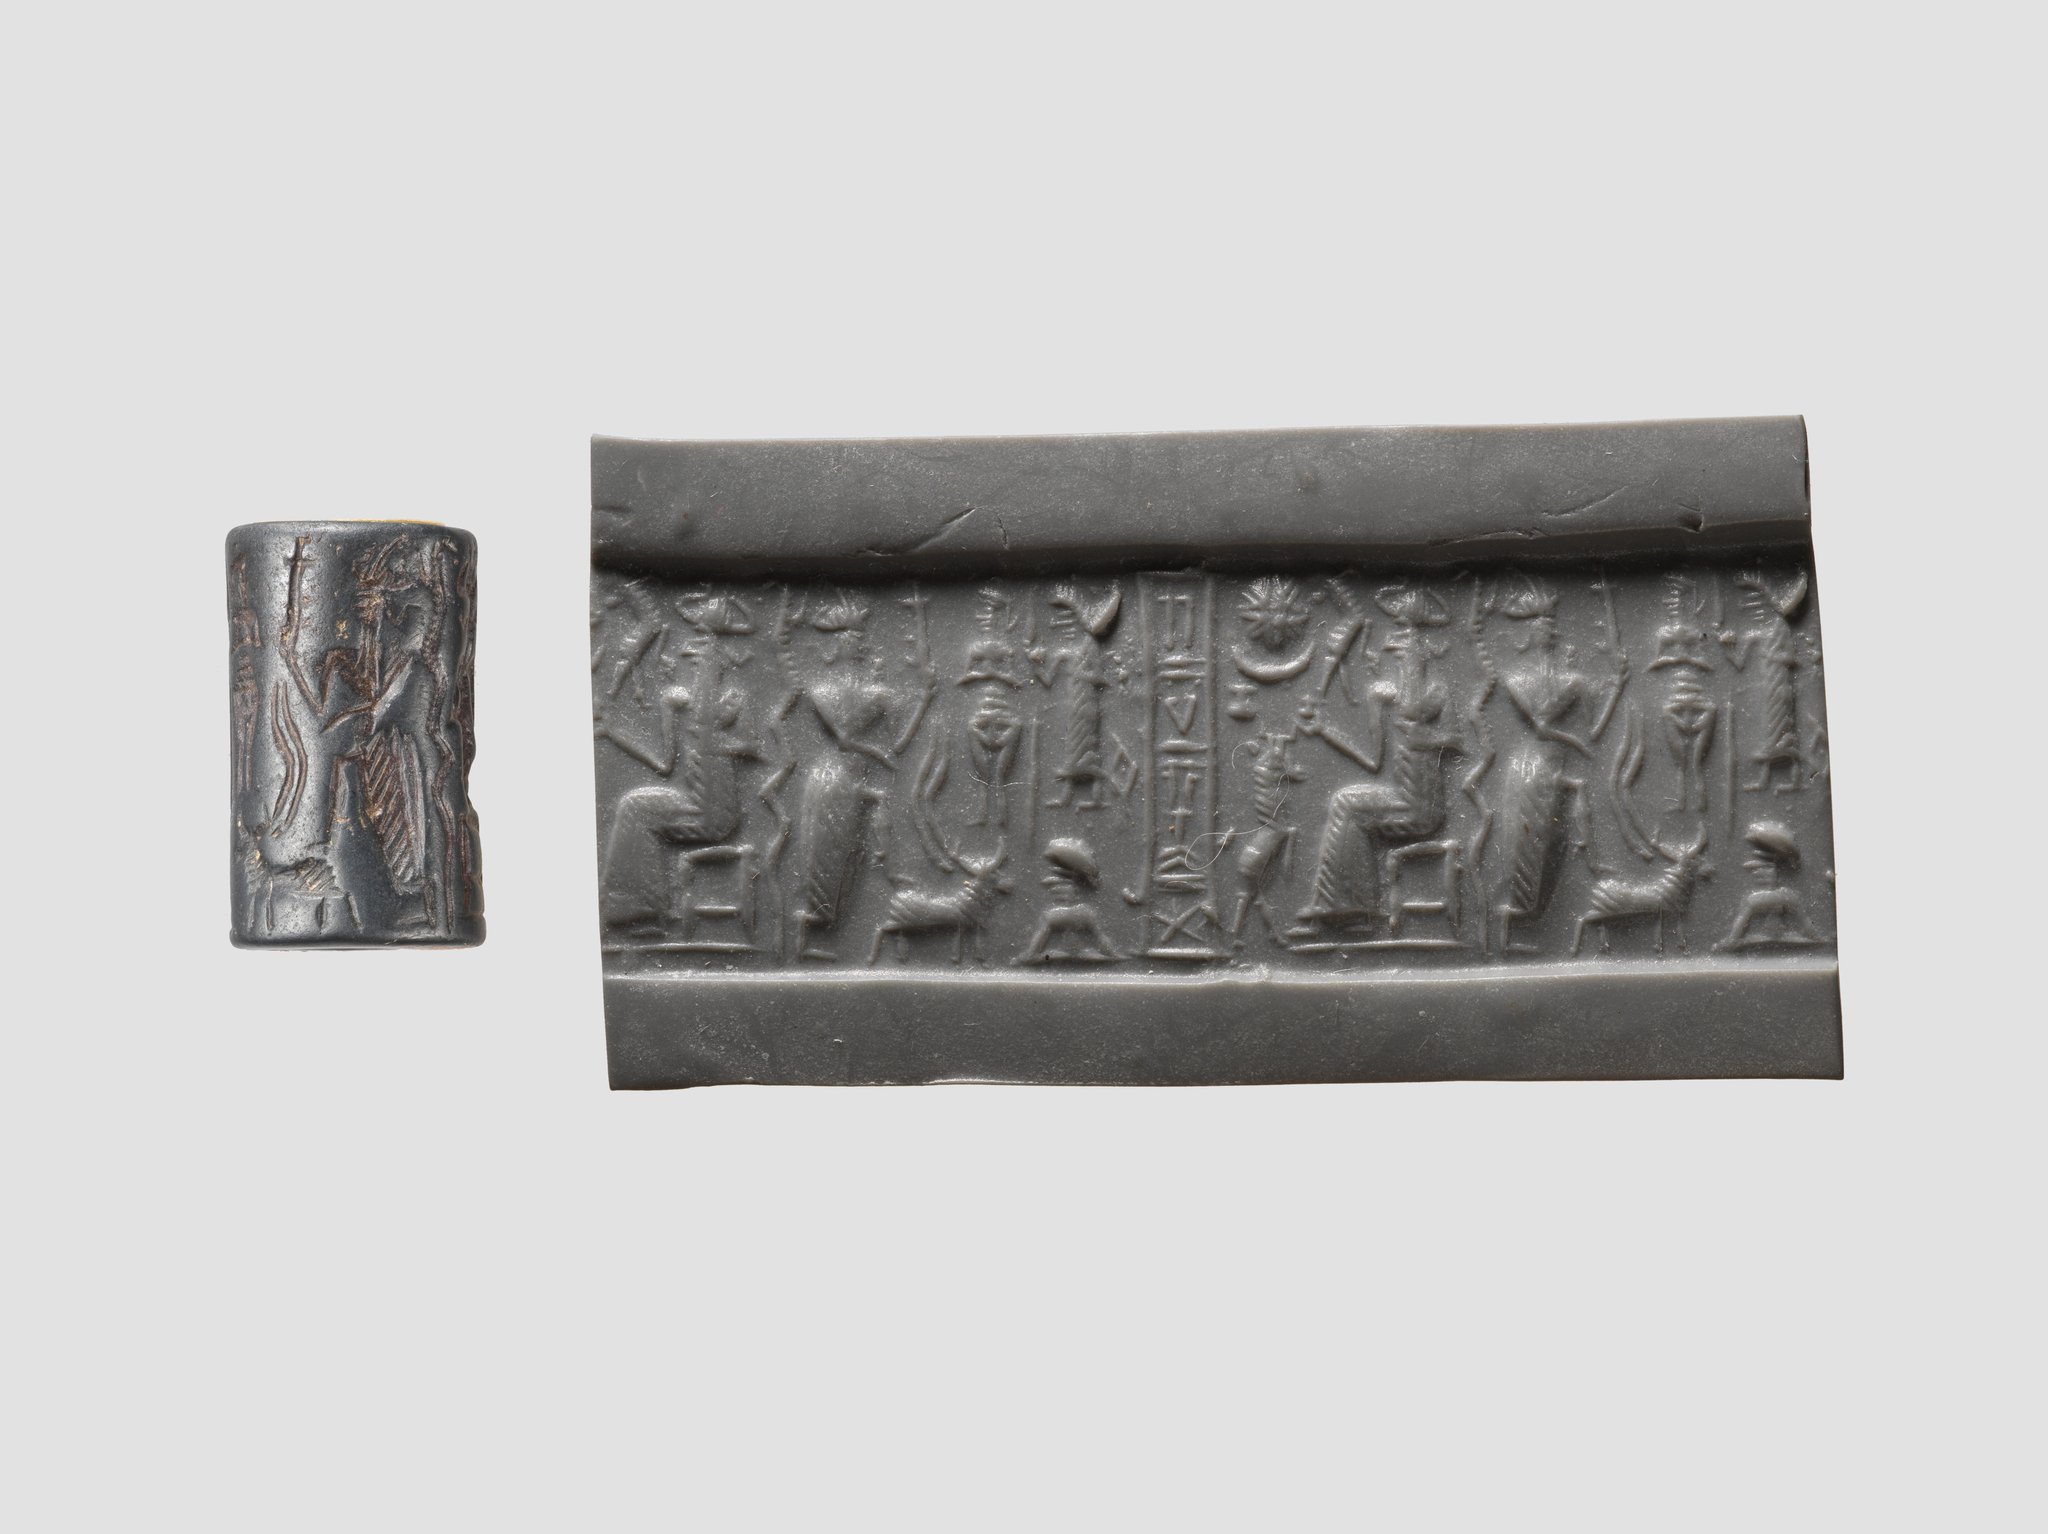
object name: cylinder seal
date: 2000-1668 BCE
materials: mineral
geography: central anatolia